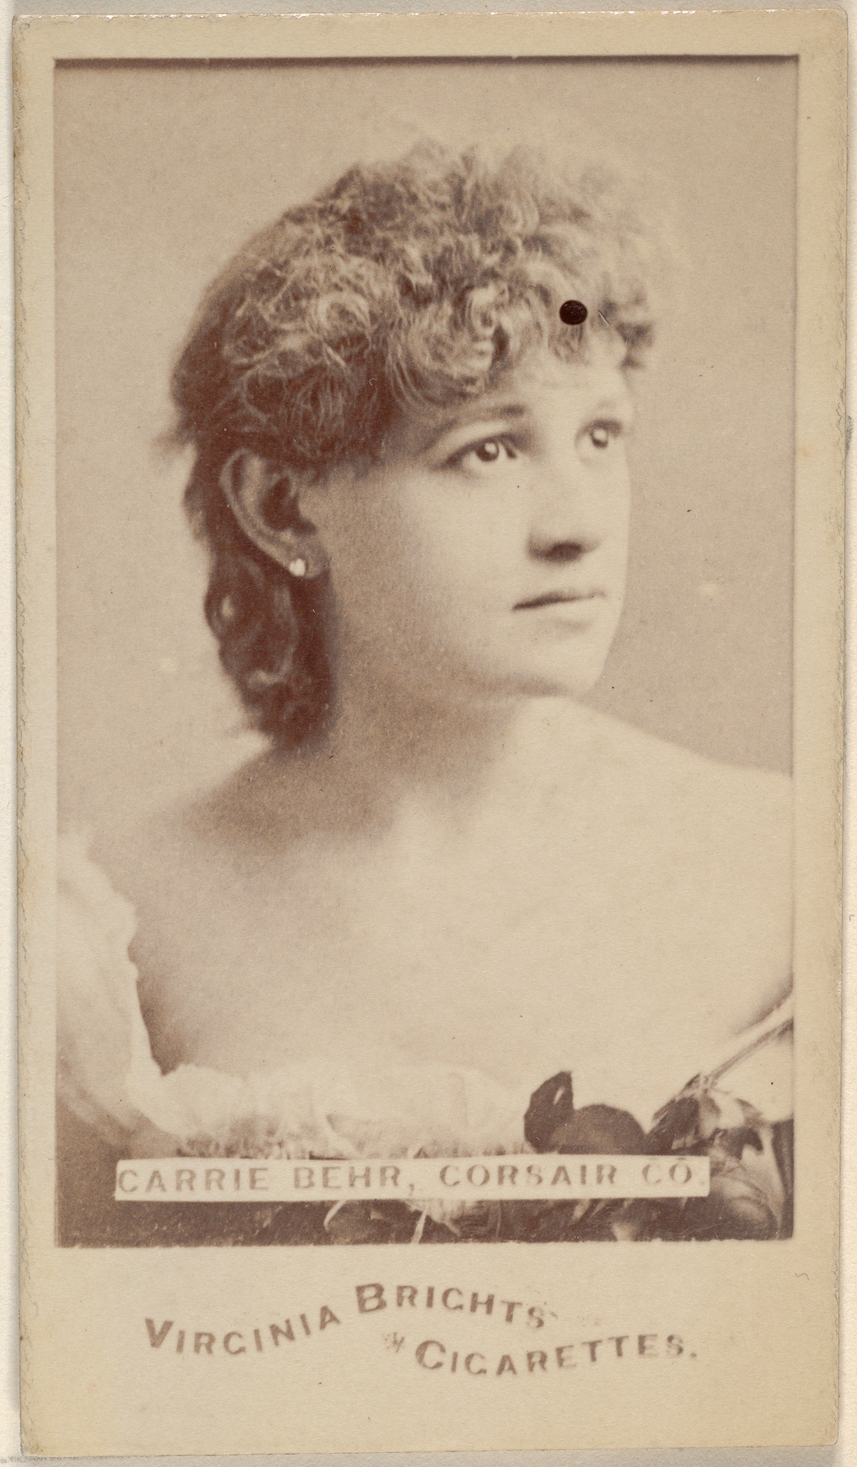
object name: photograph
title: Carrie Behr, Corsair Co., from the Actors and Actresses series (N45, Type 6) for Virginia Brights Cigarettes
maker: allen & ginter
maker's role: publisher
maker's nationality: american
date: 1888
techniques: albumen silver print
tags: portraits,women,actresses